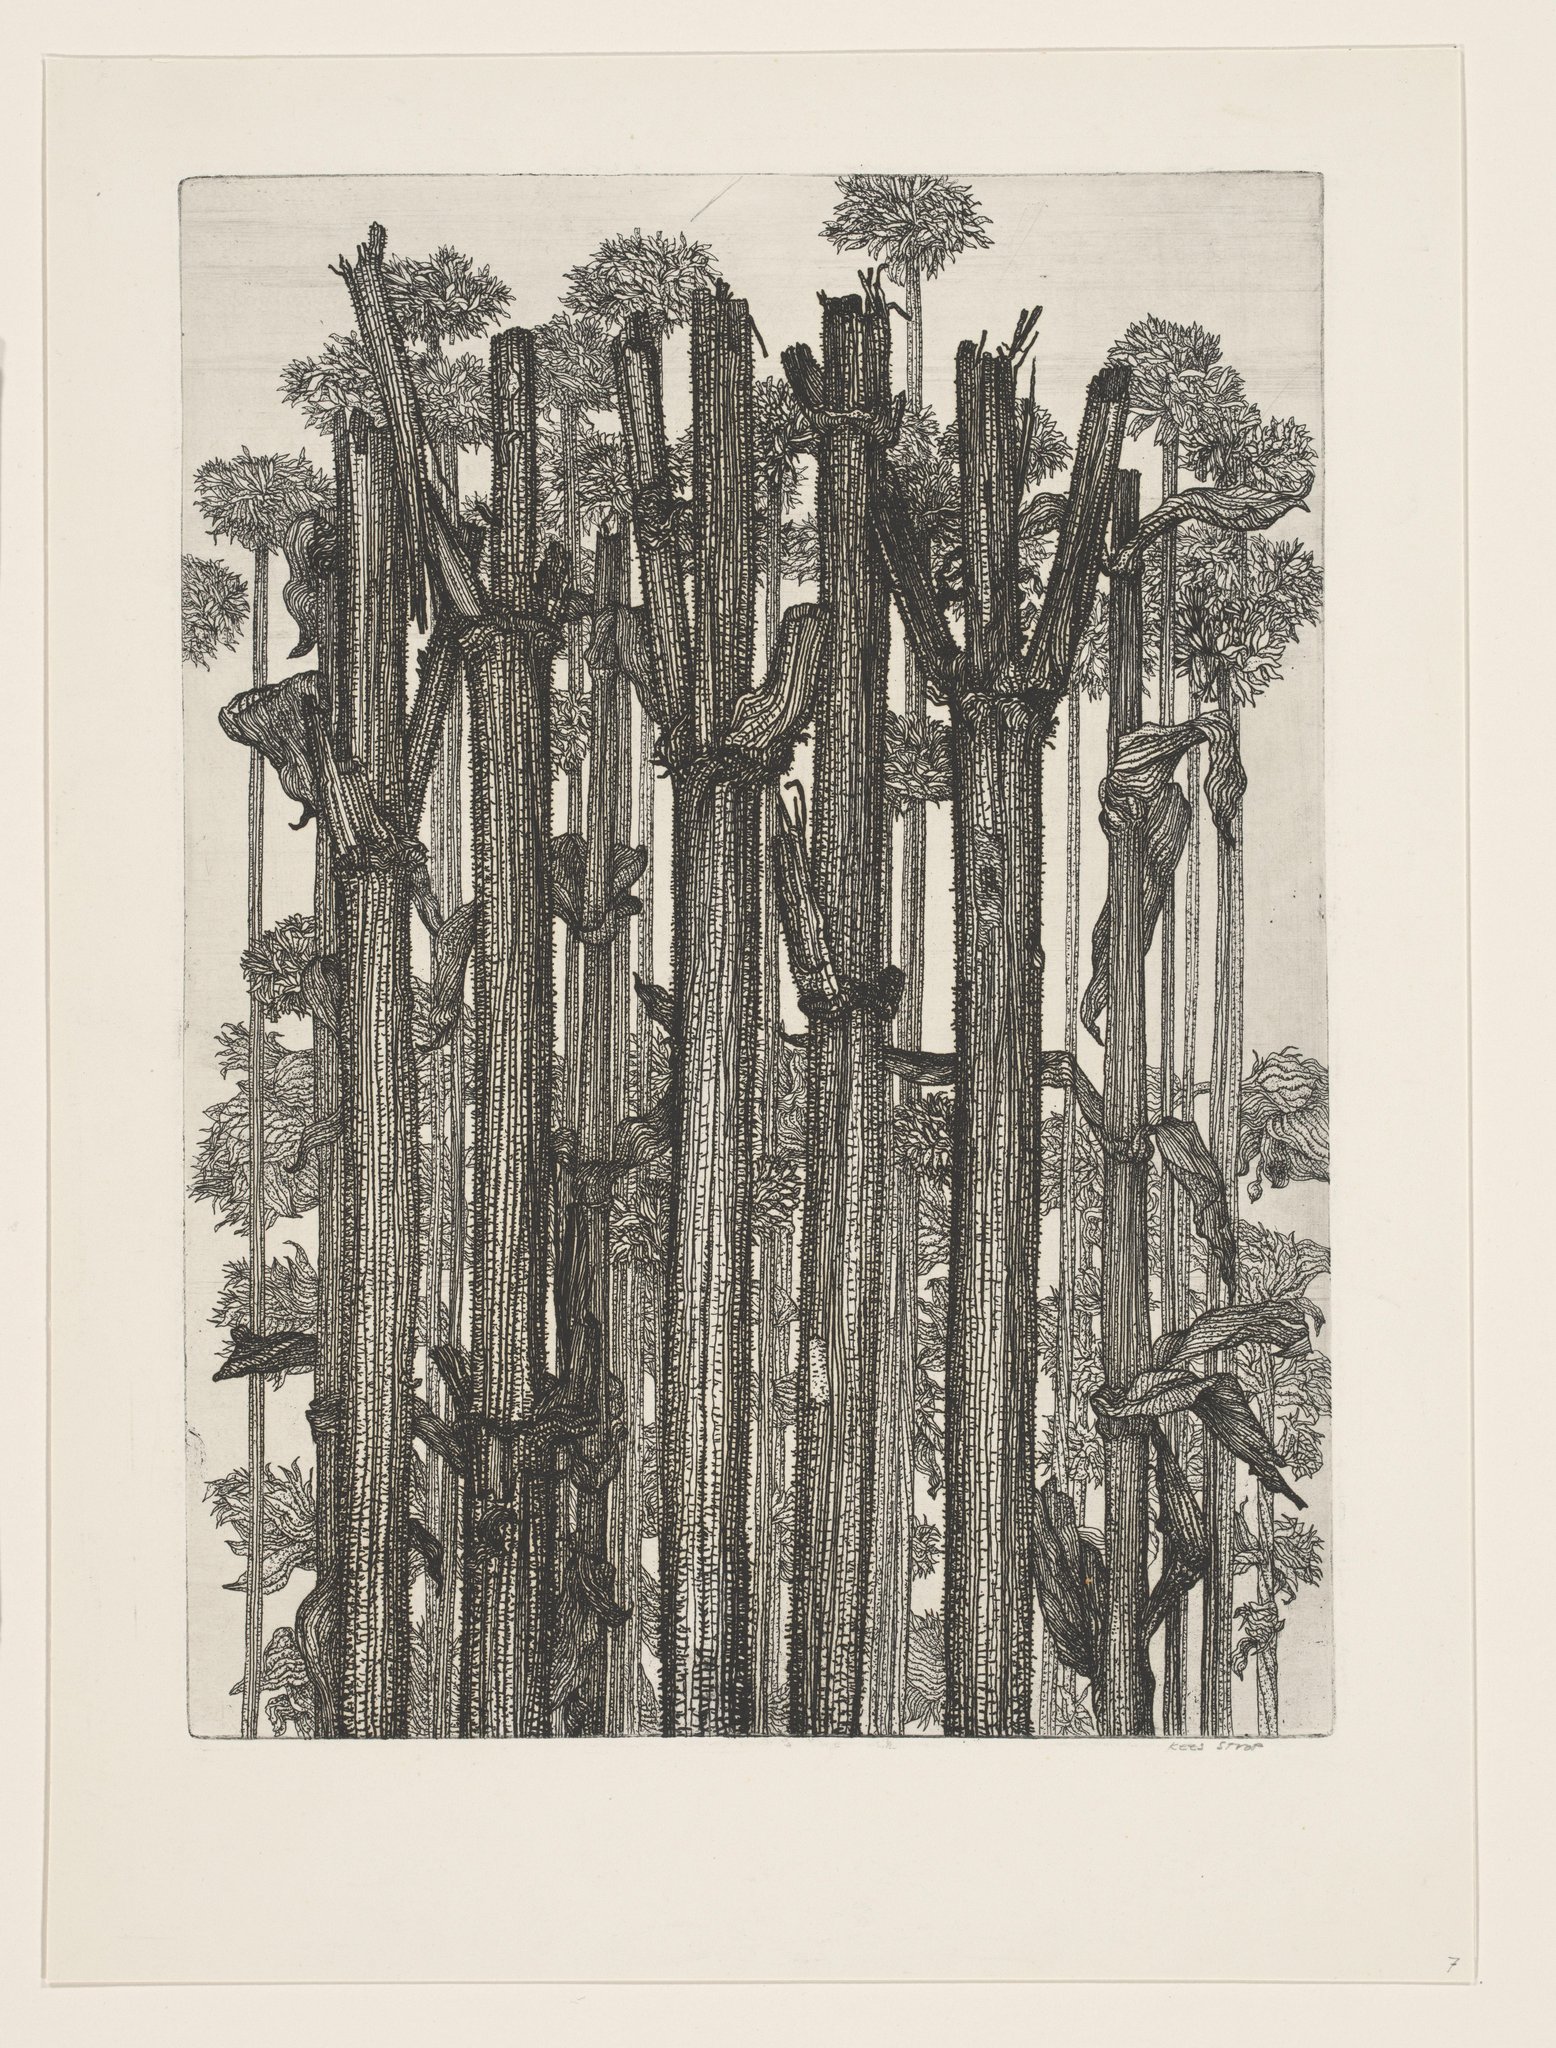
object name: print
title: Afgehakte maïsstengels met bloemen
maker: kees stoop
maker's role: draughtsman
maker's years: 1929-2019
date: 1944-1990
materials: paper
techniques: etching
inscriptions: signature: ‘KEES STOOP’